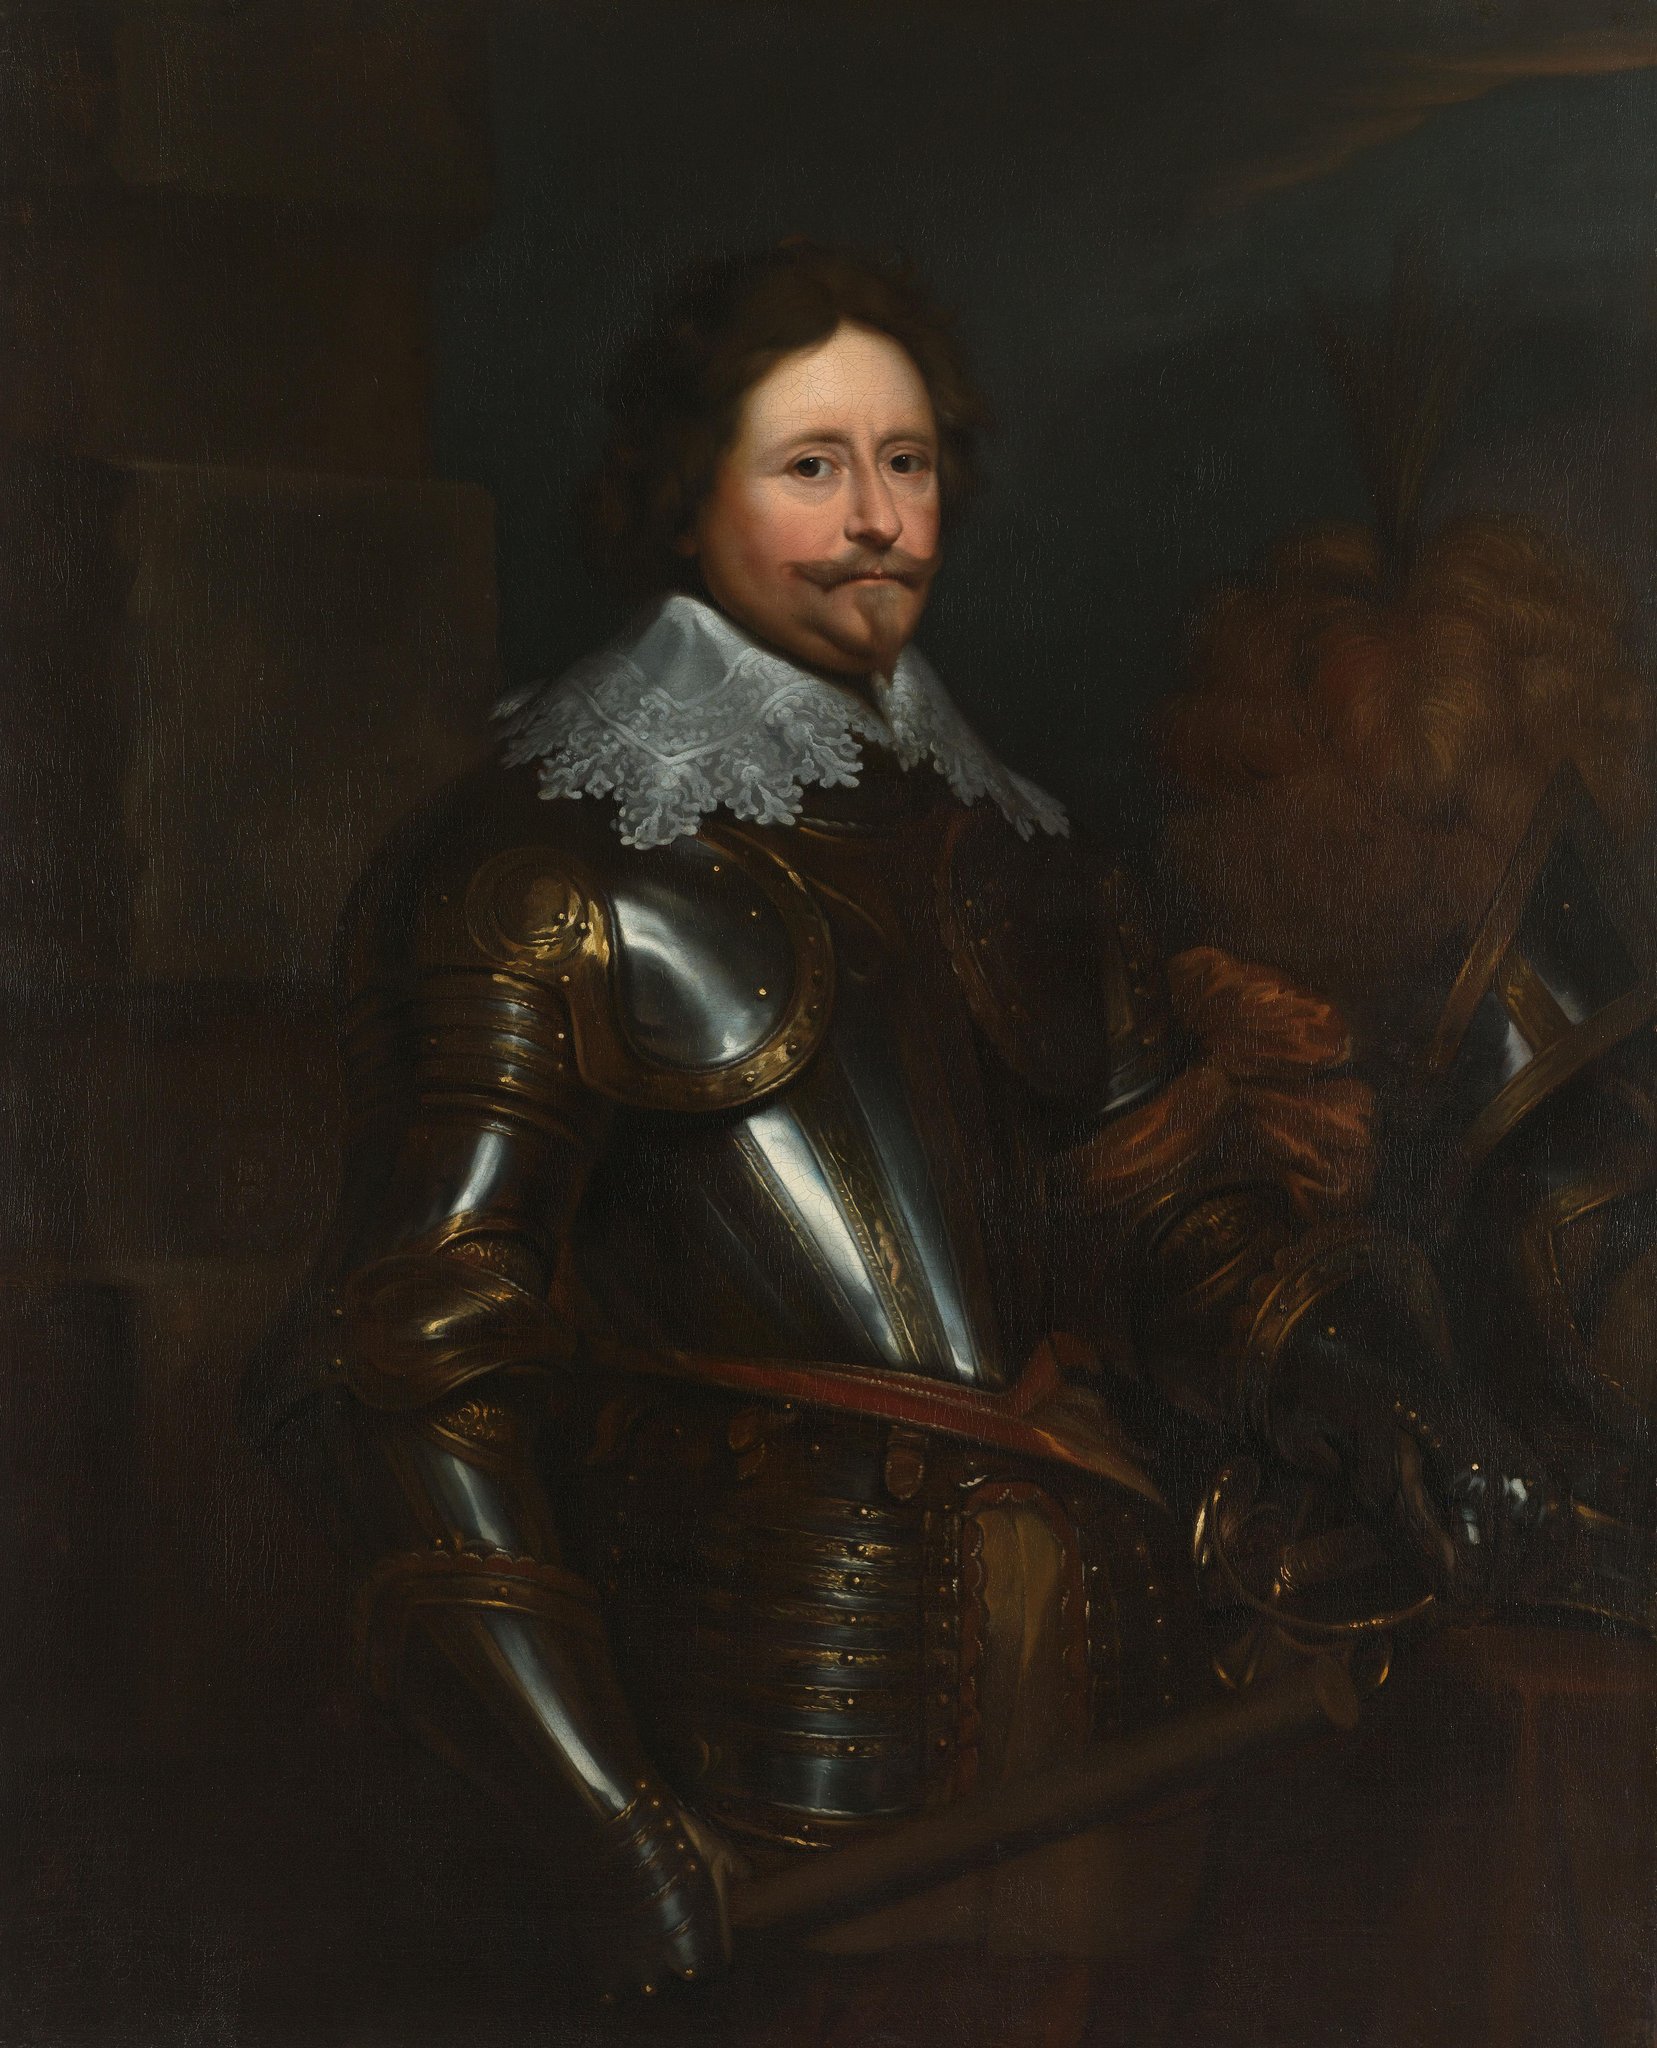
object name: painting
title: Portrait of the Stadholder Frederik Hendrik (1584-1647), Prince of Orange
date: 1670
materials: canvas, oil, paint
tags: delft, the hague, frederick henry (prince of orange), armour, historical persons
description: Portret van Frederik Hendrik, prins van Oranje. Staande, ten halven lijve, in wapenrusting met commandostaf in de rechterhand. Kopie naar het origineel in het Prado te Madrid.